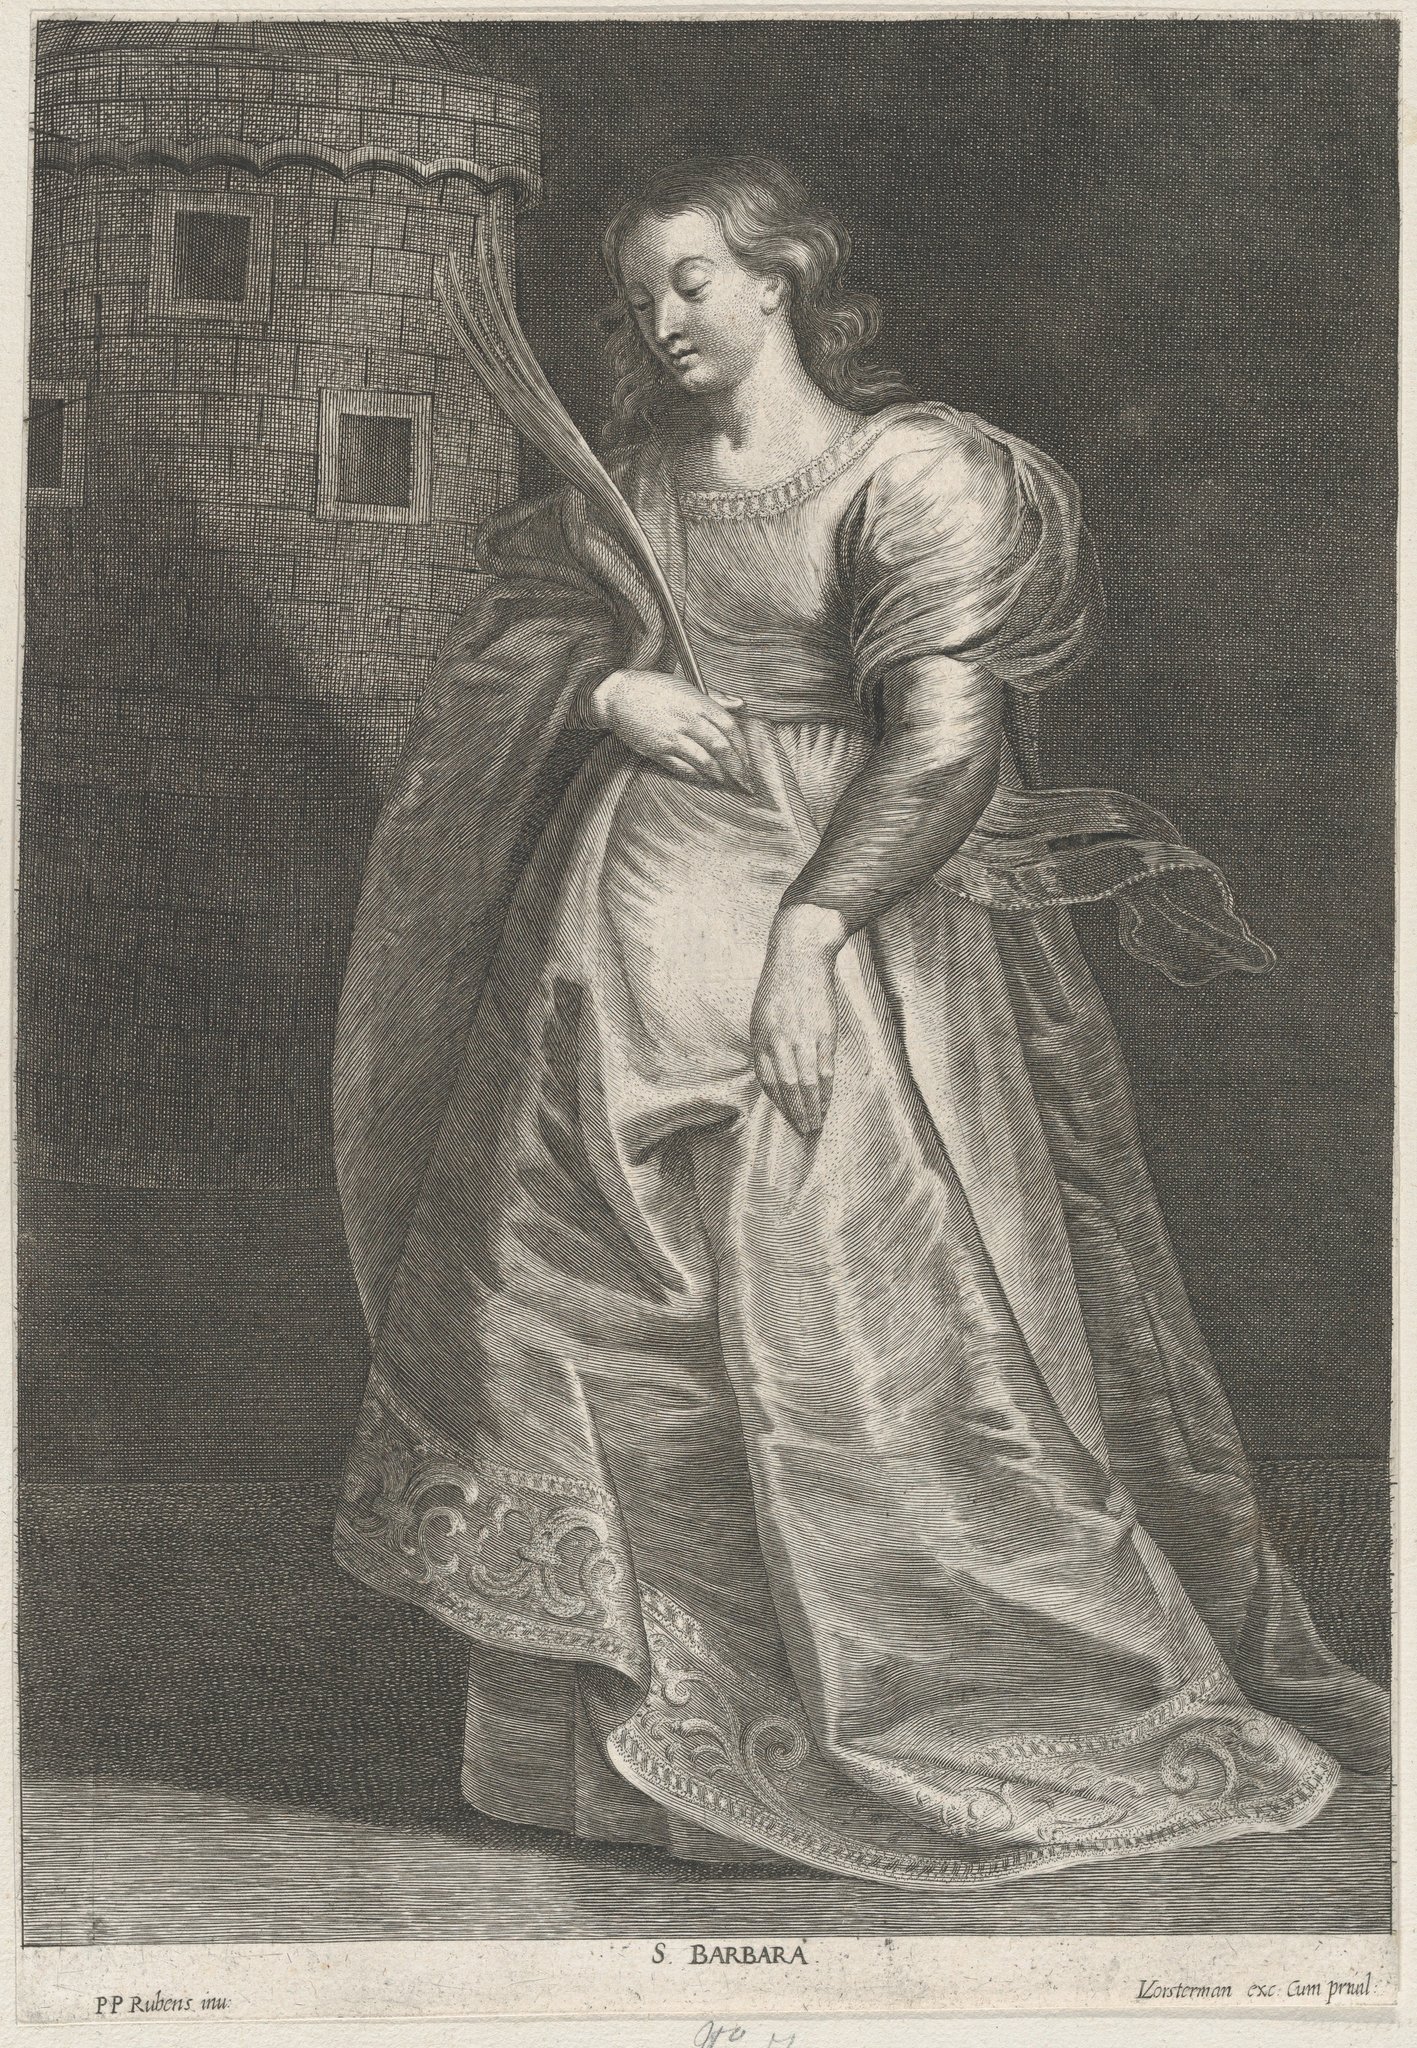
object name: print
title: Saint Barbara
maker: lucas vorsterman (i)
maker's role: artist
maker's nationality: flemish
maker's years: 1595-1675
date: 1615-1675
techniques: engraving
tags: women,saints